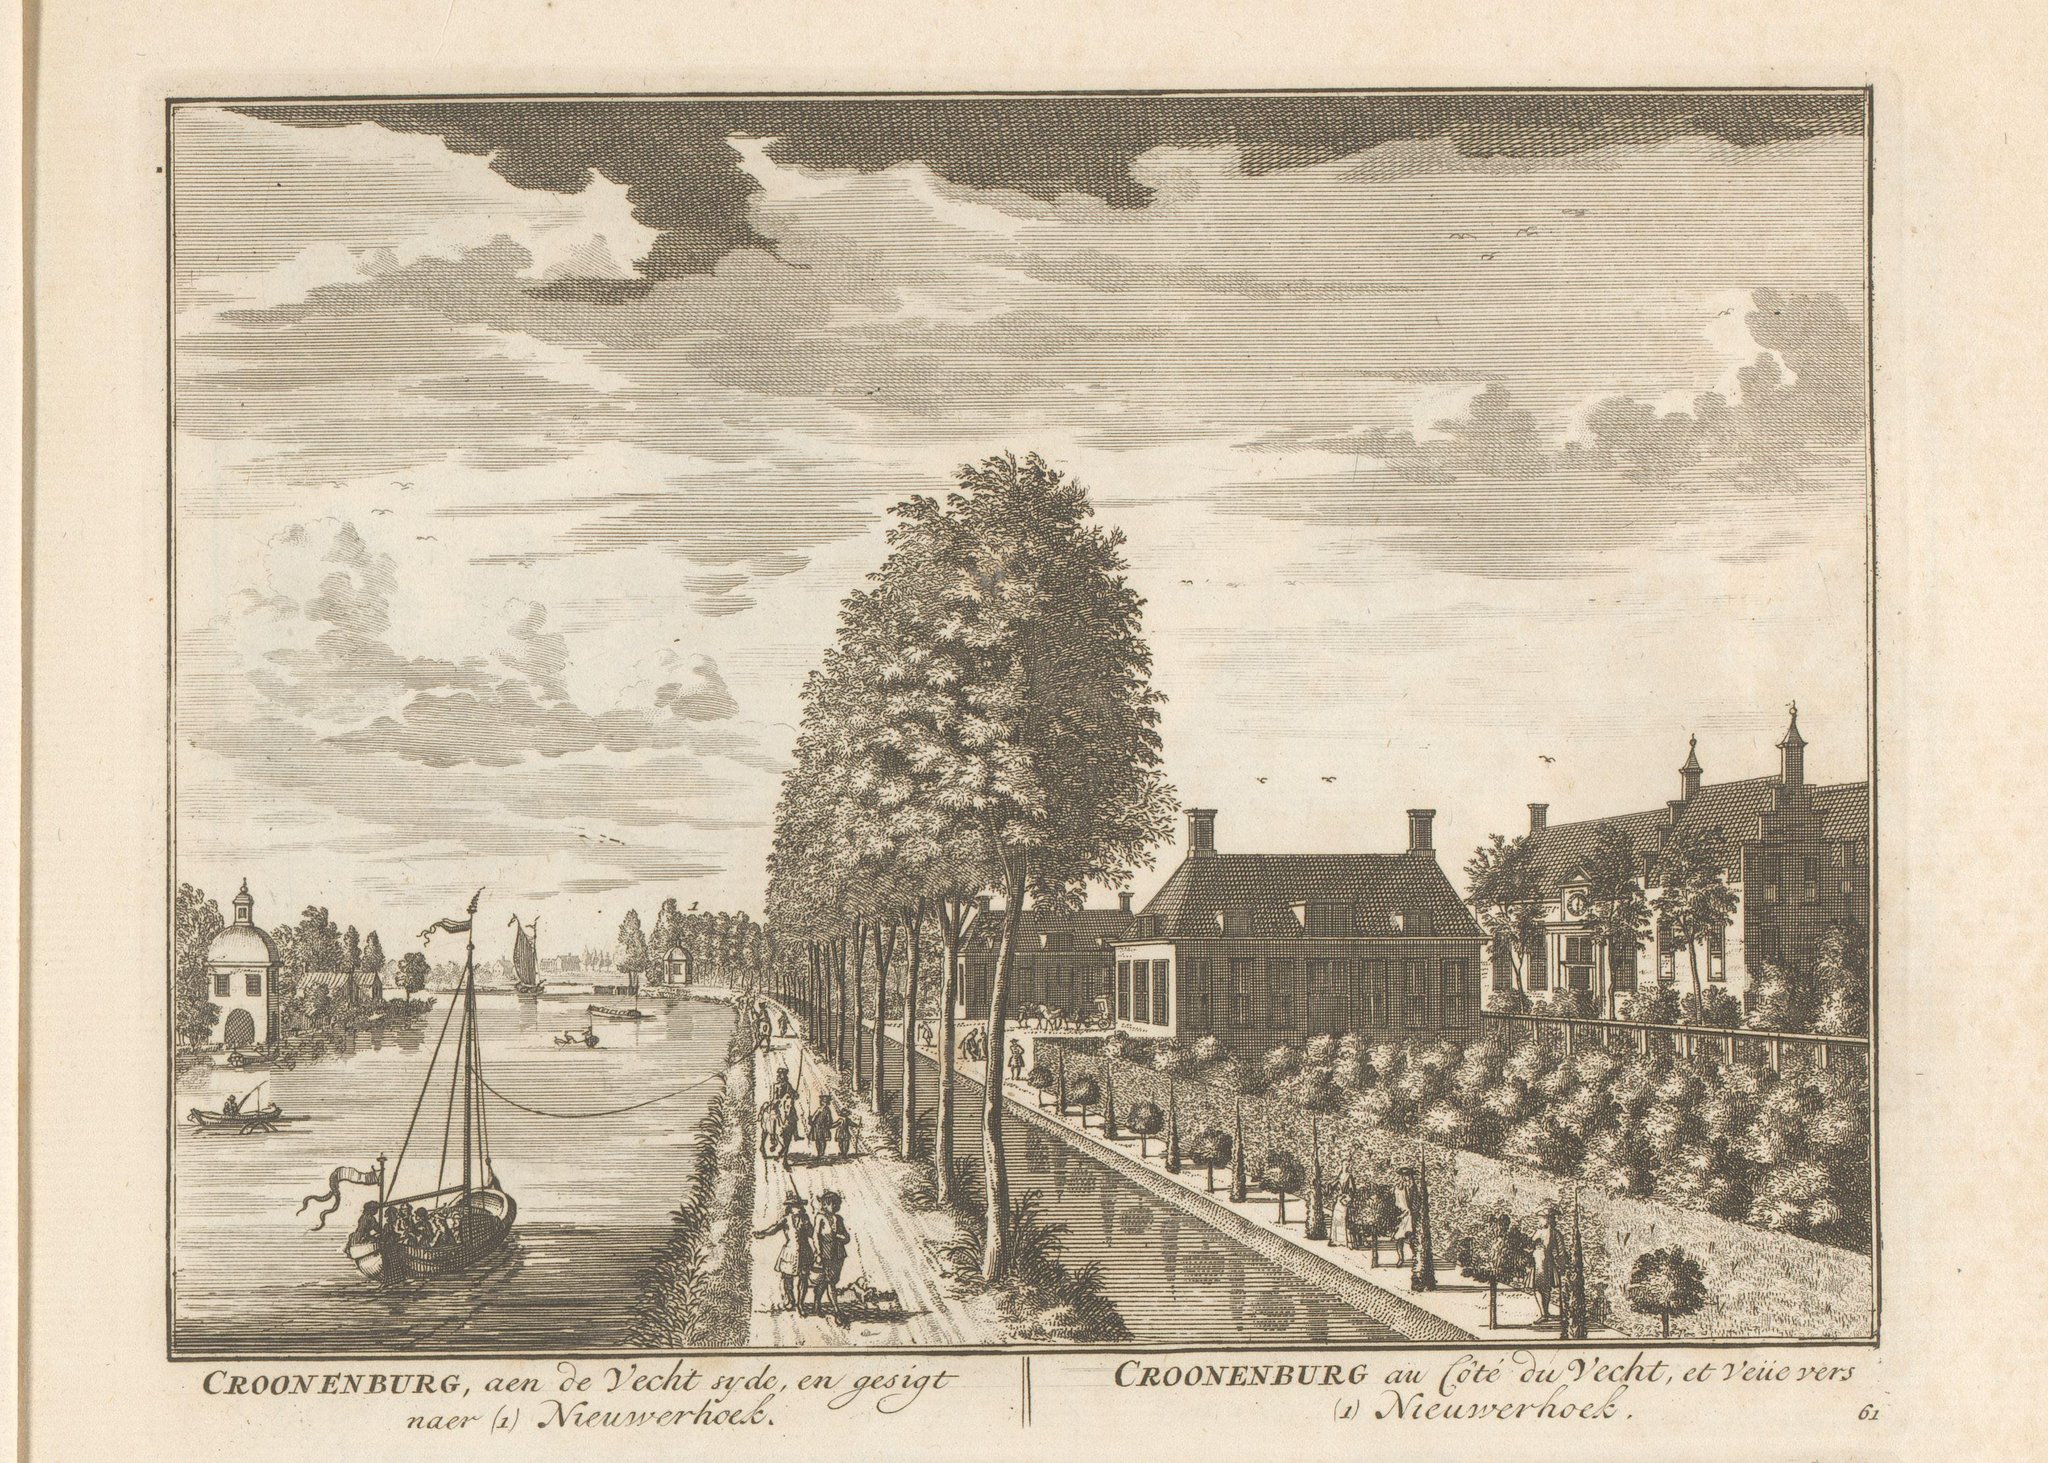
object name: album leaf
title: Gezicht op de buitenplaats Cronenburgh aan de Vecht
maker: daniël stopendaal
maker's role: print maker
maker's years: 1672-1726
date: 1790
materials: paper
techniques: engraving, etching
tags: river (+ landscape with figures, staffage), country-house, vecht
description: Prent gebruikt in: Leth, Andries de. De zegepraalende Vecht, vertoonende verscheidene gesichten van lustplaatsen, heeren huysen en dorpen, beginnende van Uitrecht en met Muyden besluytende (...). Amsterdam: Weduwe Nicolaus Visscher, 1719. Prent ook gebruikt in: Brouërius van Nidek, Matthaeus. De Vechtstroom, van Utrecht tot Muiden (...). Amsterdam: H. Gartman, W. Vermandel en J.W. Smit, 1790.